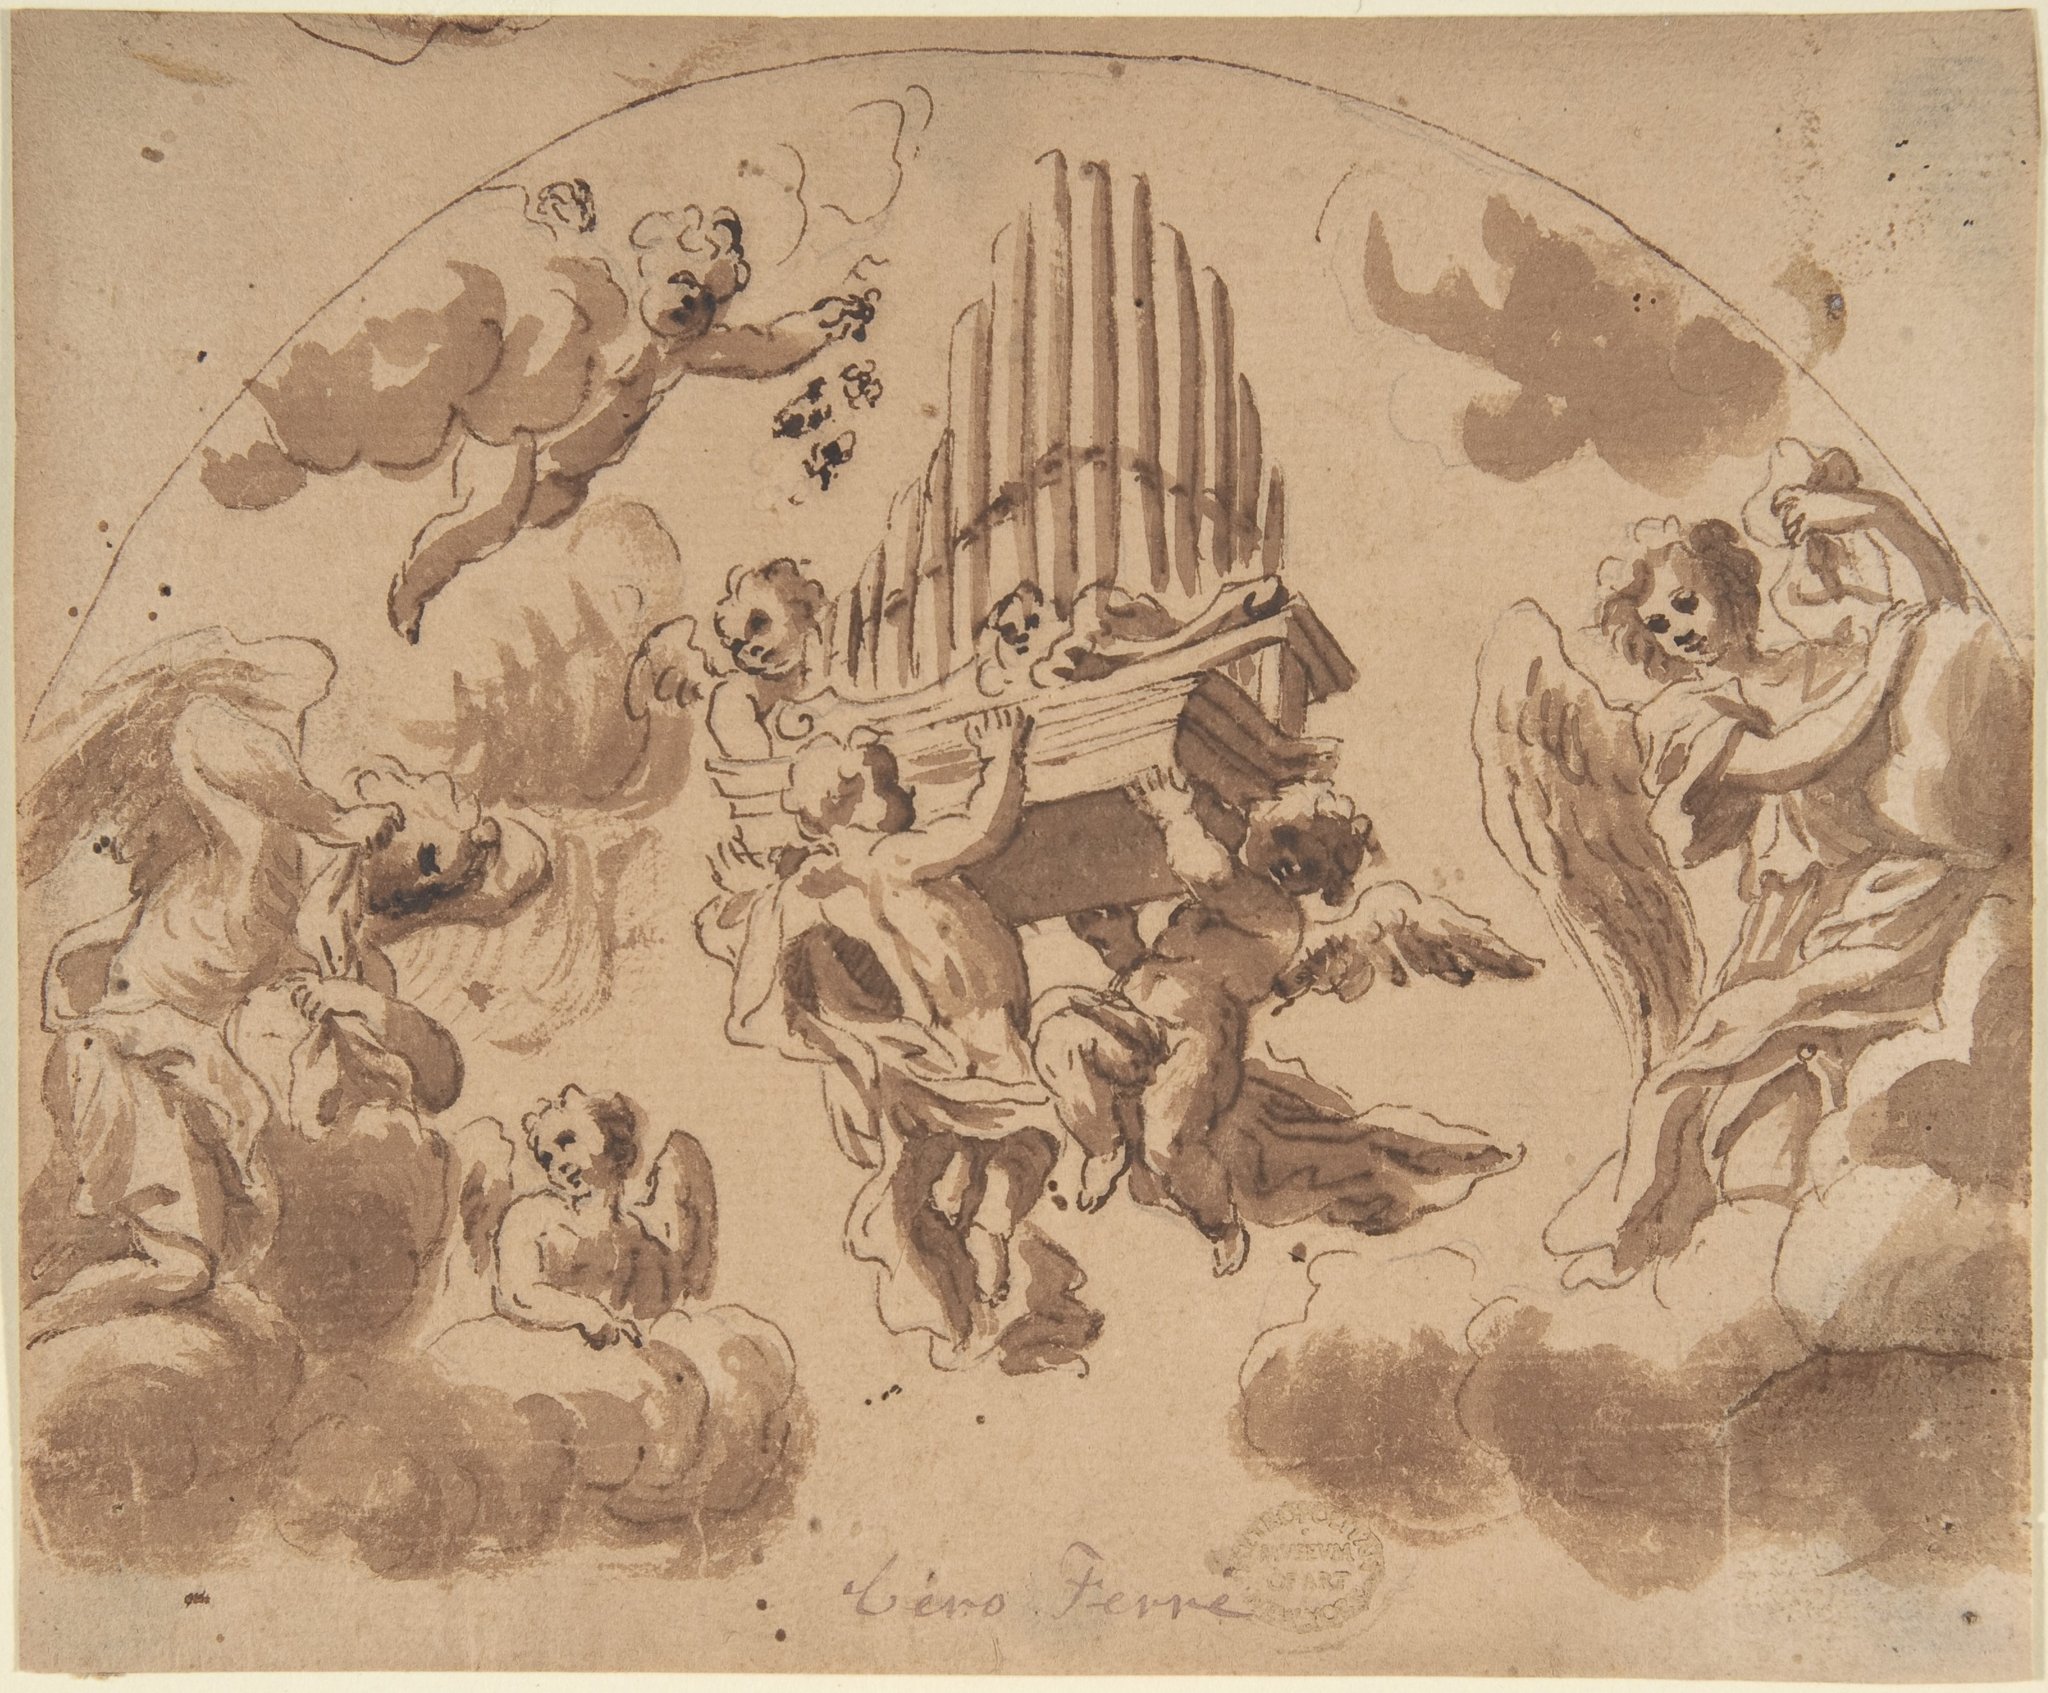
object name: drawing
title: Putti Carrying Organ Pipes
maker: anonymous, italian, roman-bolognese, 17th century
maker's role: artist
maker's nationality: italian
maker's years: 1600-1700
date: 1601-1700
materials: chalk, ink, paper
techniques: brush, pen, wash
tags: musical instruments,putti